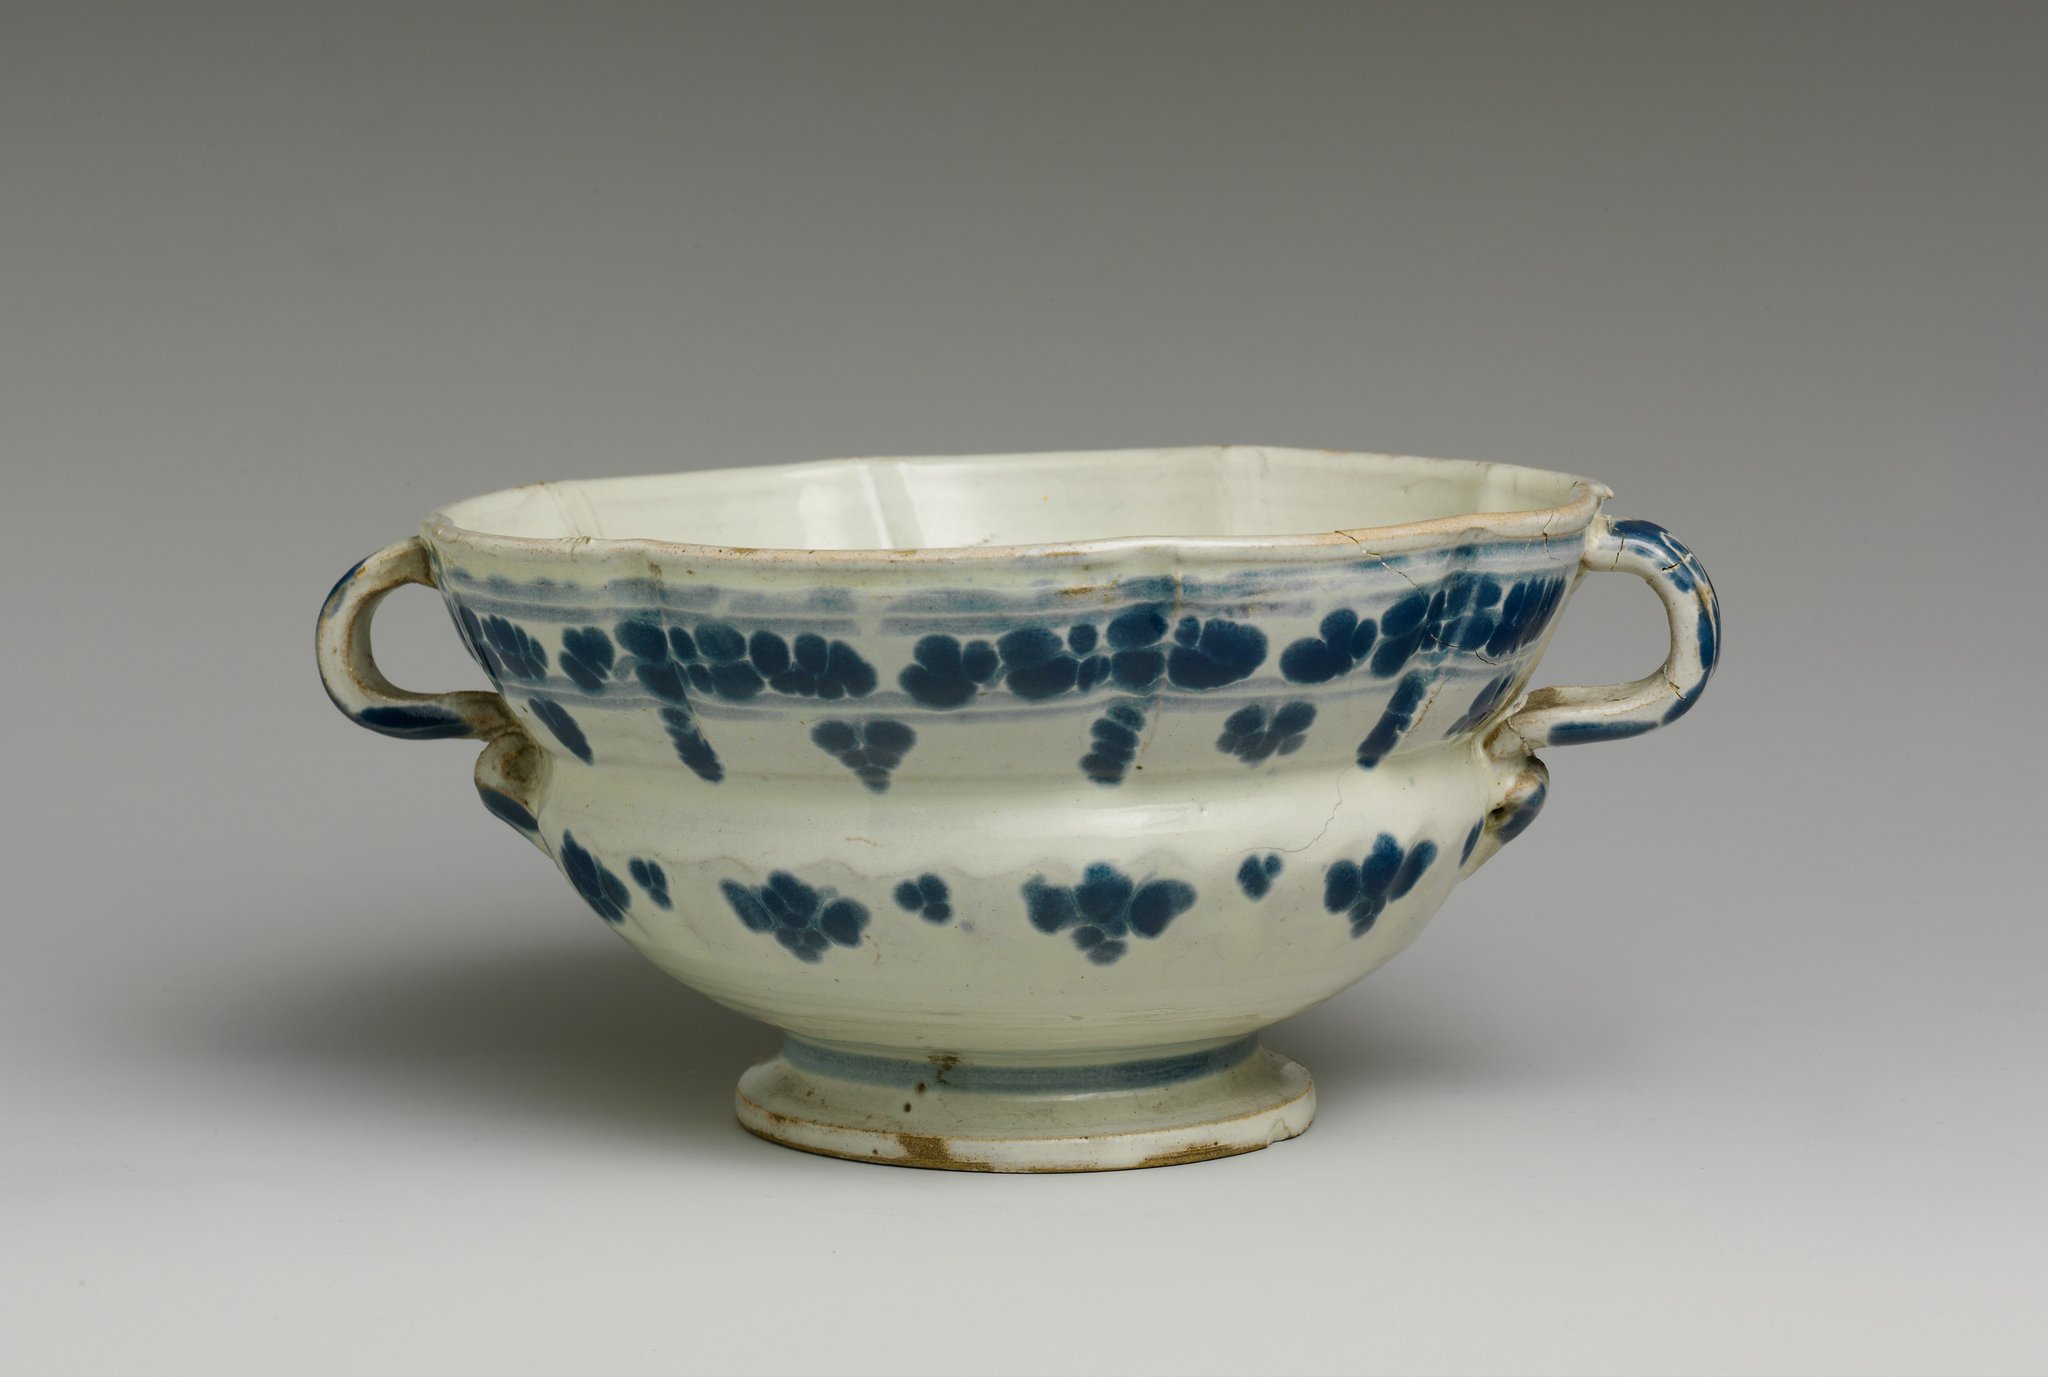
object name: bowl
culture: mexican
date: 1750-1800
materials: earthenware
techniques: glazing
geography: mexico